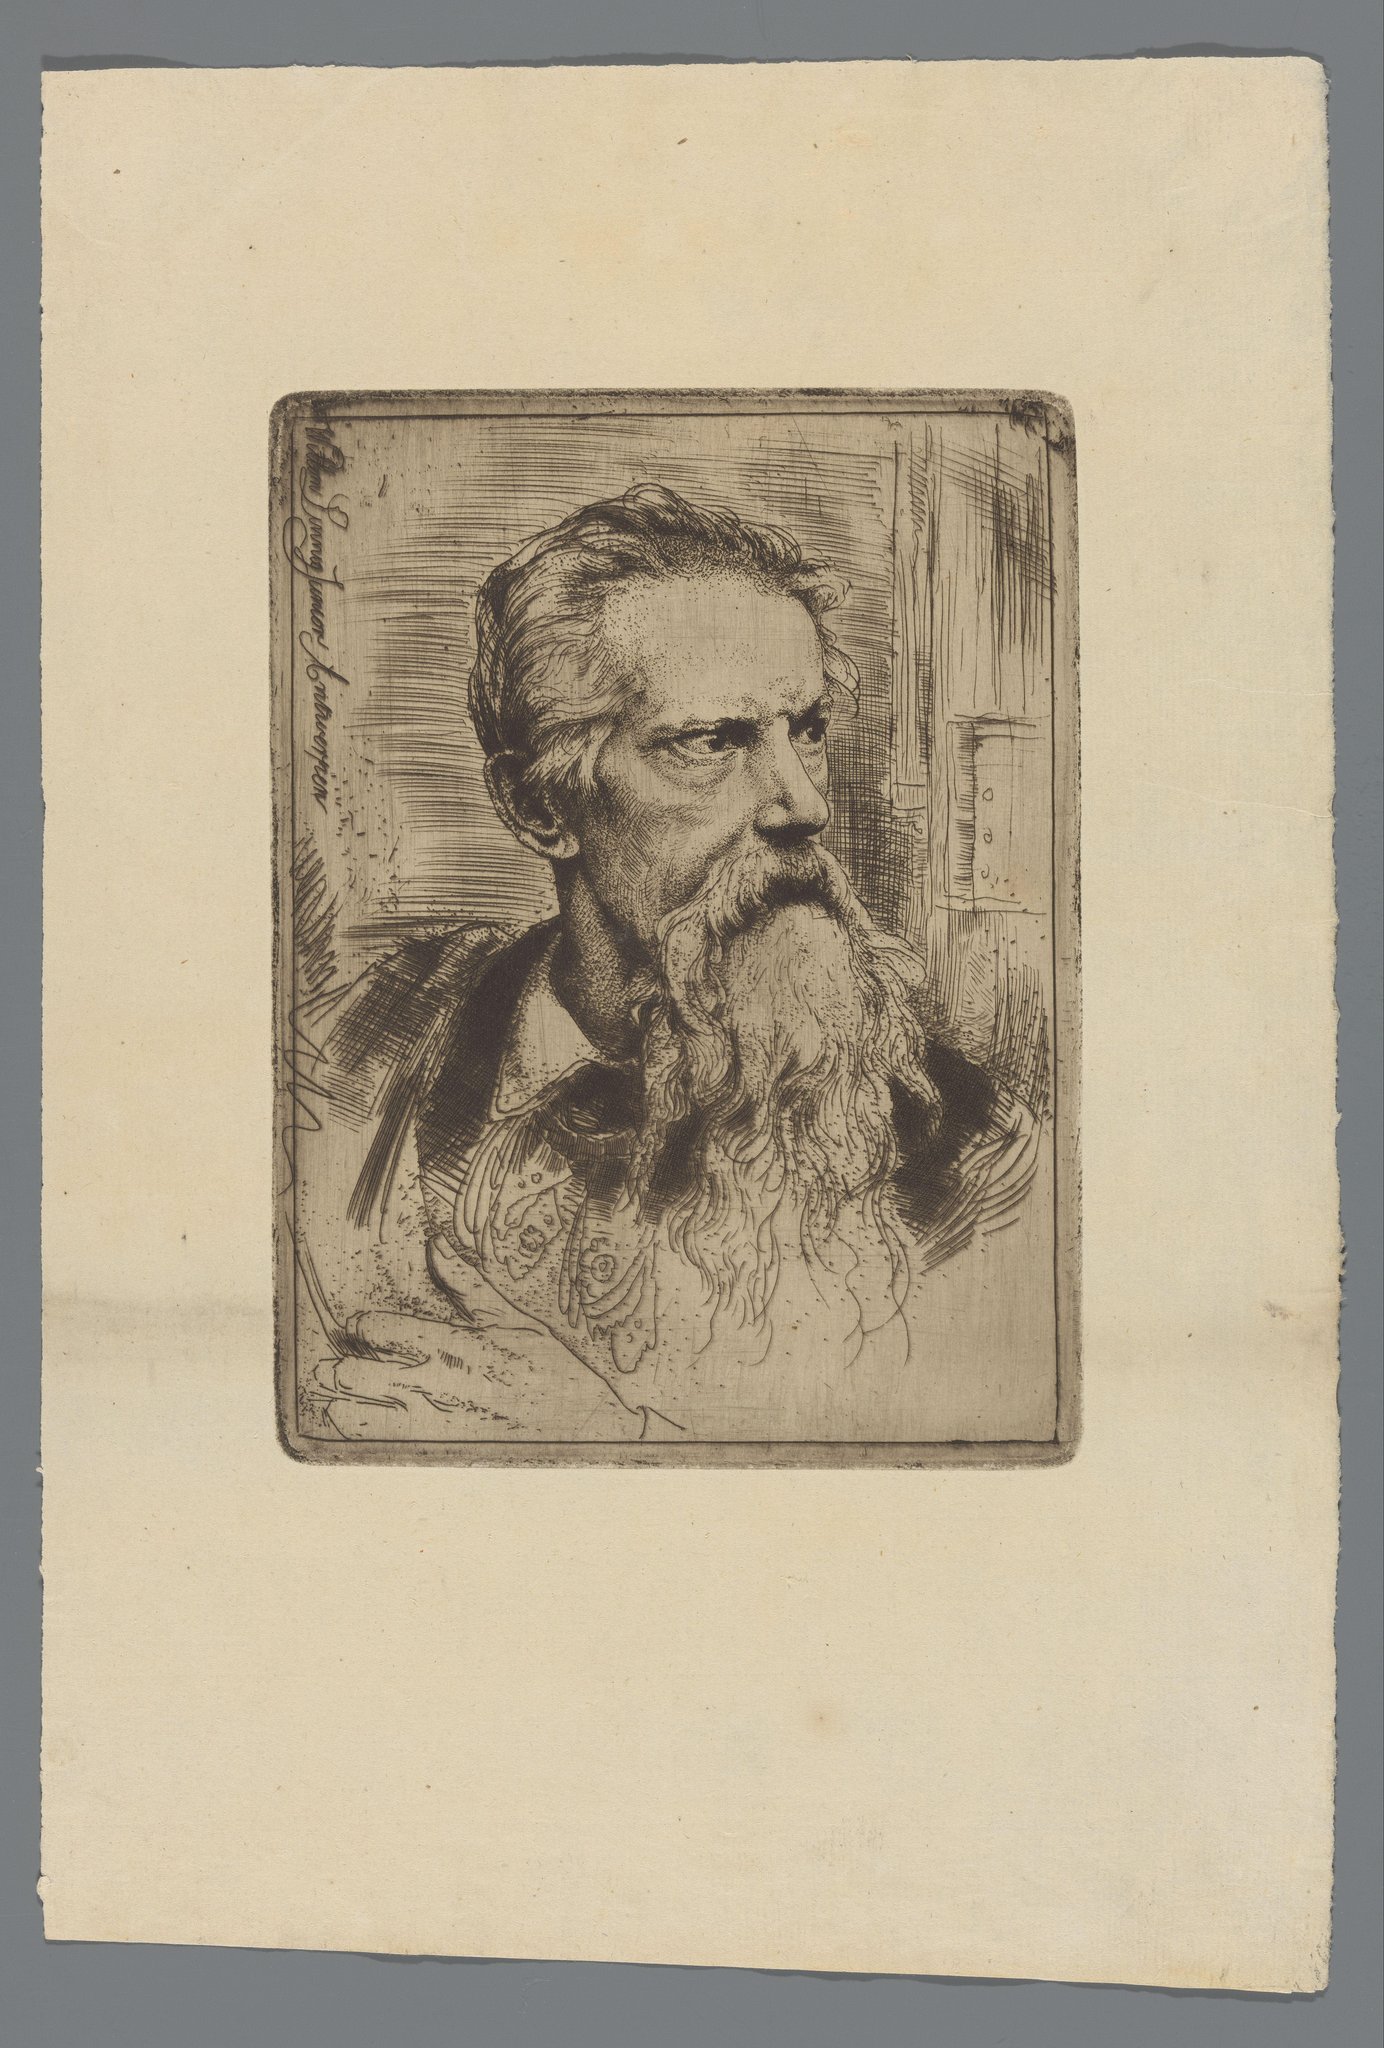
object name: print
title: Portret van Franz Liszt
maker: willem linnig (ii)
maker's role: print maker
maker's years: 1842-1890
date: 1852-1889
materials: paper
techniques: drypoint, etching, intaglio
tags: historical persons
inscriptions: collector's mark: Lugt 2228